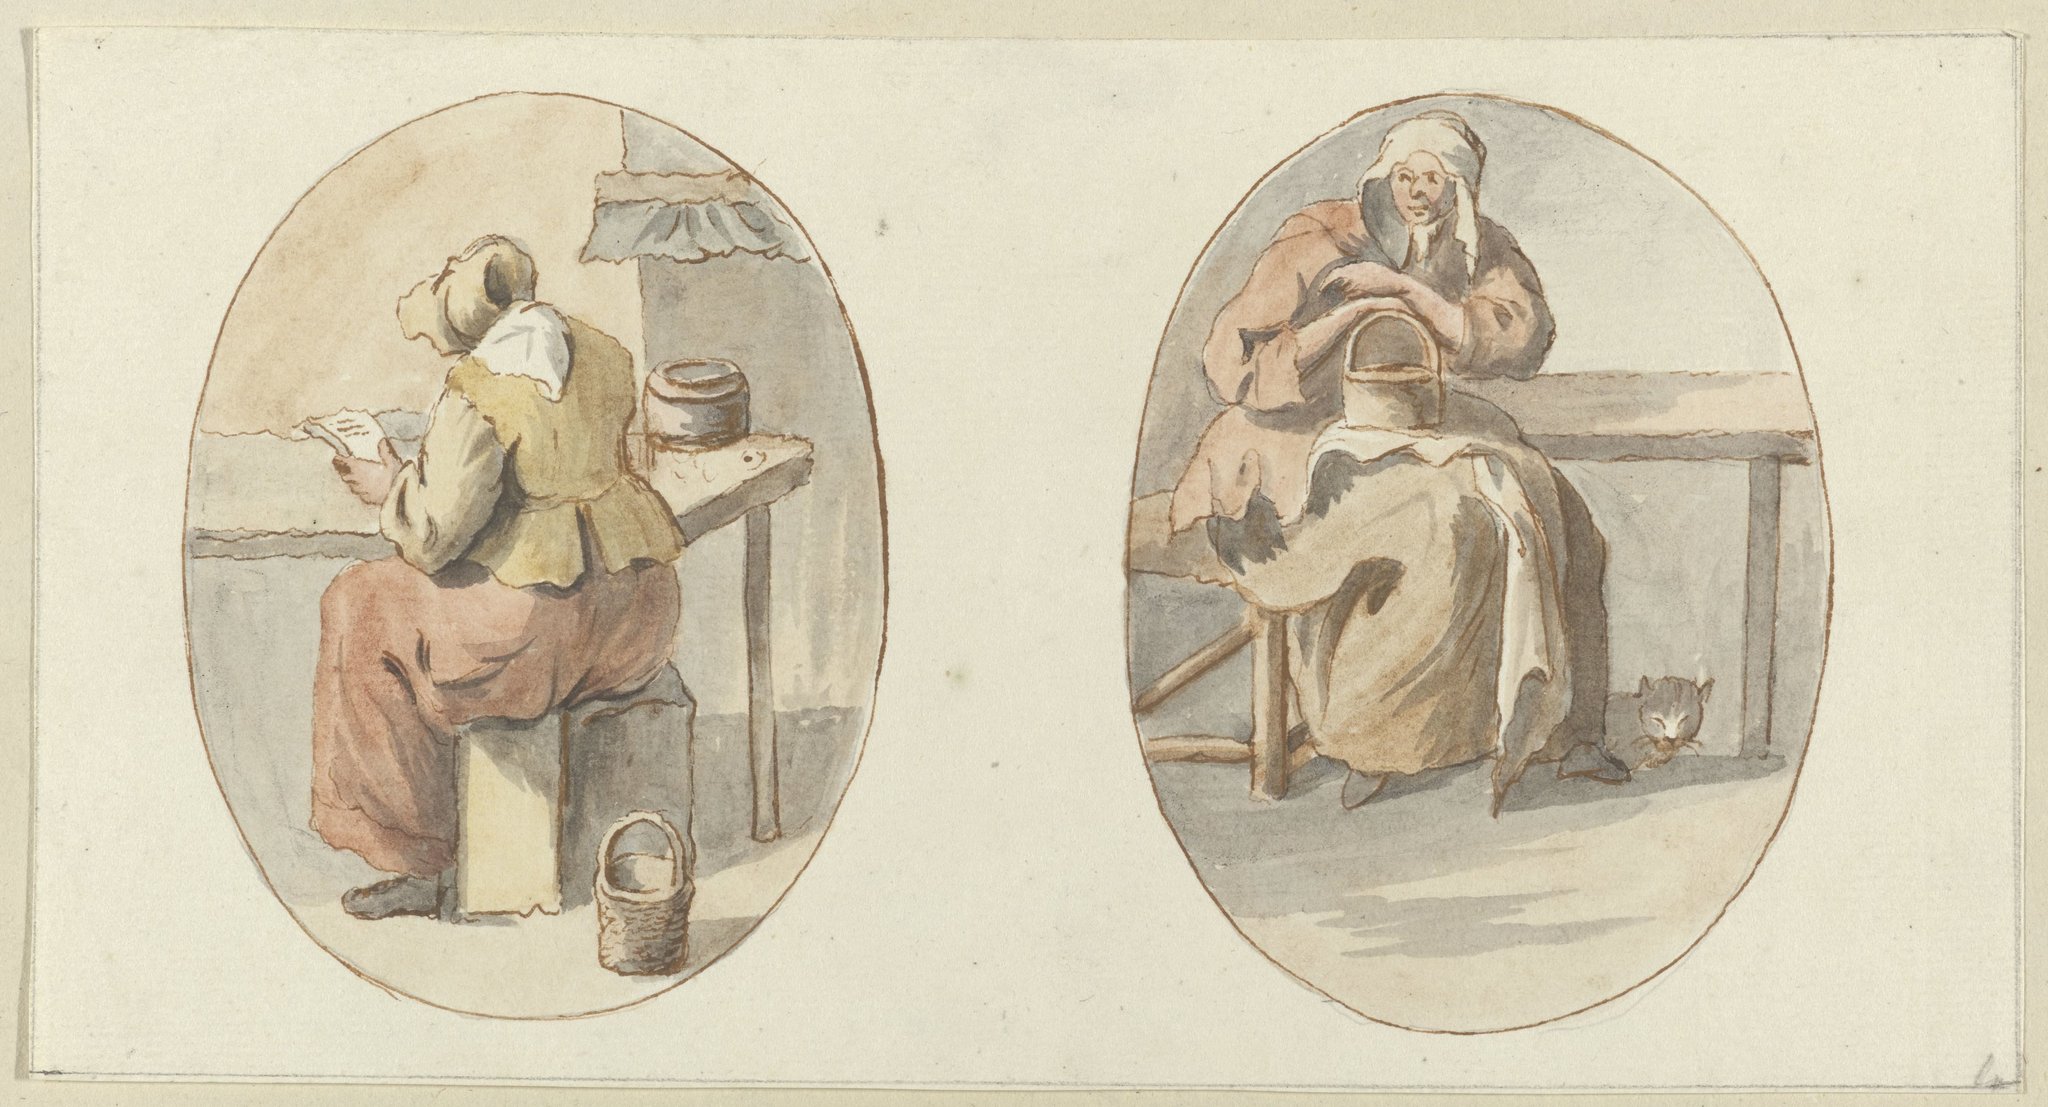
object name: drawing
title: Zittende vrouw met brief en zittende vrouw met kat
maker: Anonymous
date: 1700-1799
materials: ink, paper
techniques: brush, pen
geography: netherlands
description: In twee staande ovalen elk een tekening. In de linkerovaal een zittende lezende vrouw. In de rechterovaal een zittende vrouw met een kat aan haar voeten.